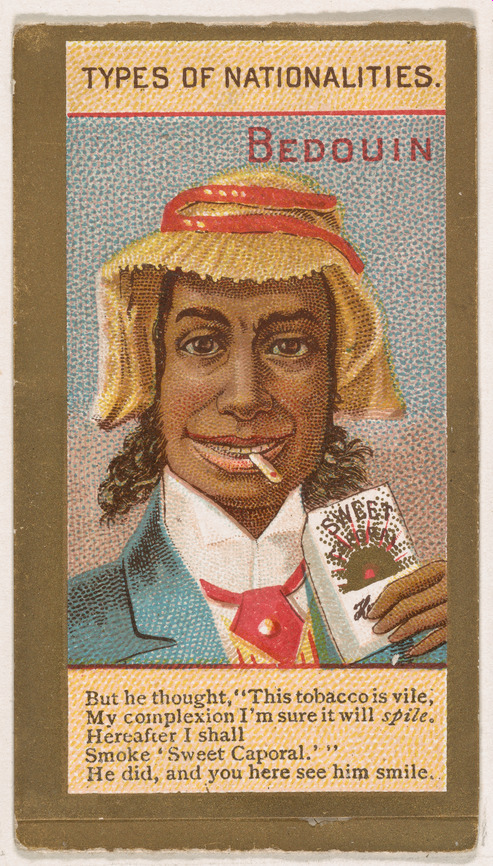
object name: print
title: Bedouin, from Types of Nationalities (N240) issued by Kinney Bros.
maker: kinney brothers tobacco company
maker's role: publisher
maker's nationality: american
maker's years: 1869-2011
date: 1890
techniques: color lithograph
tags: men,smoking